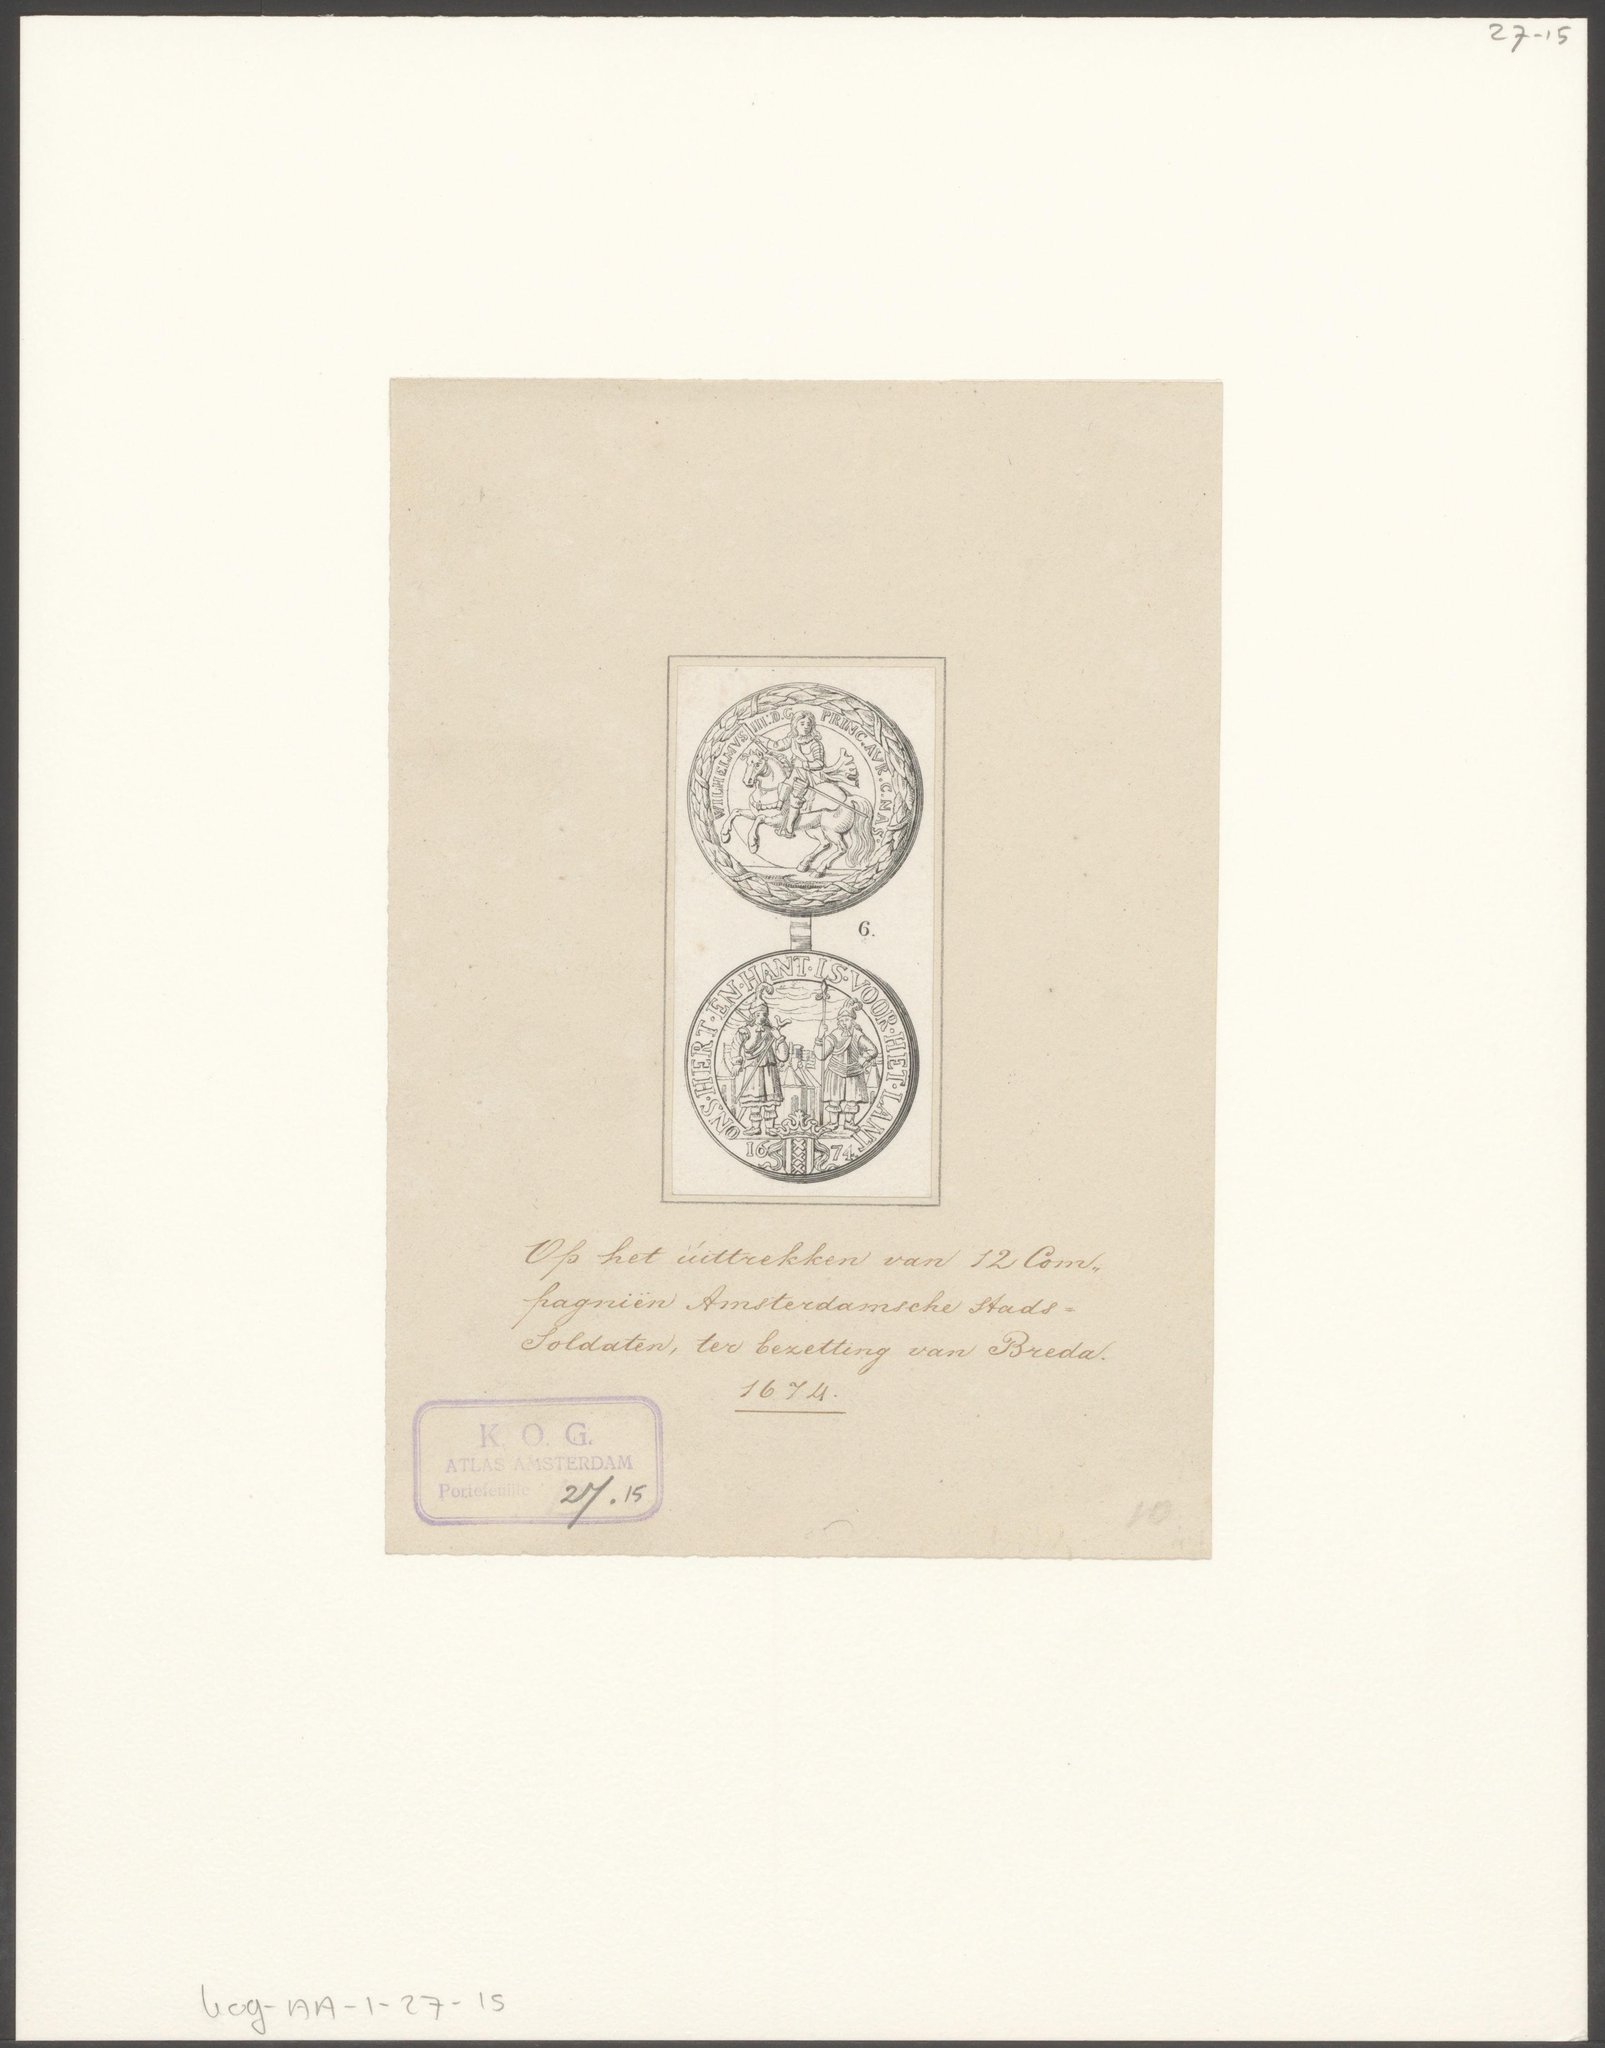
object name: book illustration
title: Penning op het uittrekken van twaalf compagnieën van de Amsterdamse schutterij voor de bezetting van Breda, 1674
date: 1829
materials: paper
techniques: lithograph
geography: amsterdam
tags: the hague, william iii (prince of orange and king of england, scotland, and ireland), riding a horse, ass, or mule; rider, horseman, coat of arms (as symbol of the state, etc.) (+ city; municipal), medal (considered as a piece of sculpture, regardless of its specific function), the soldier; the soldier's life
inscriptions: collector's mark: Lugt 1641b, inscription: ‘Op het uittrekken van 12 Com- / pagniën Amsterdamsche stads- / soldaten, ter bezetting van Breda. / 1674’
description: Prent uit: Vries, Jeronimo de, en Johannes Cornelis de Jonge. Nederlandsche gedenkpenningen verklaard, en met verdere bijdragen tot de penningkunde. Den Haag en Amsterdam: Gebroeders van Cleef, 1829, pl. IX.